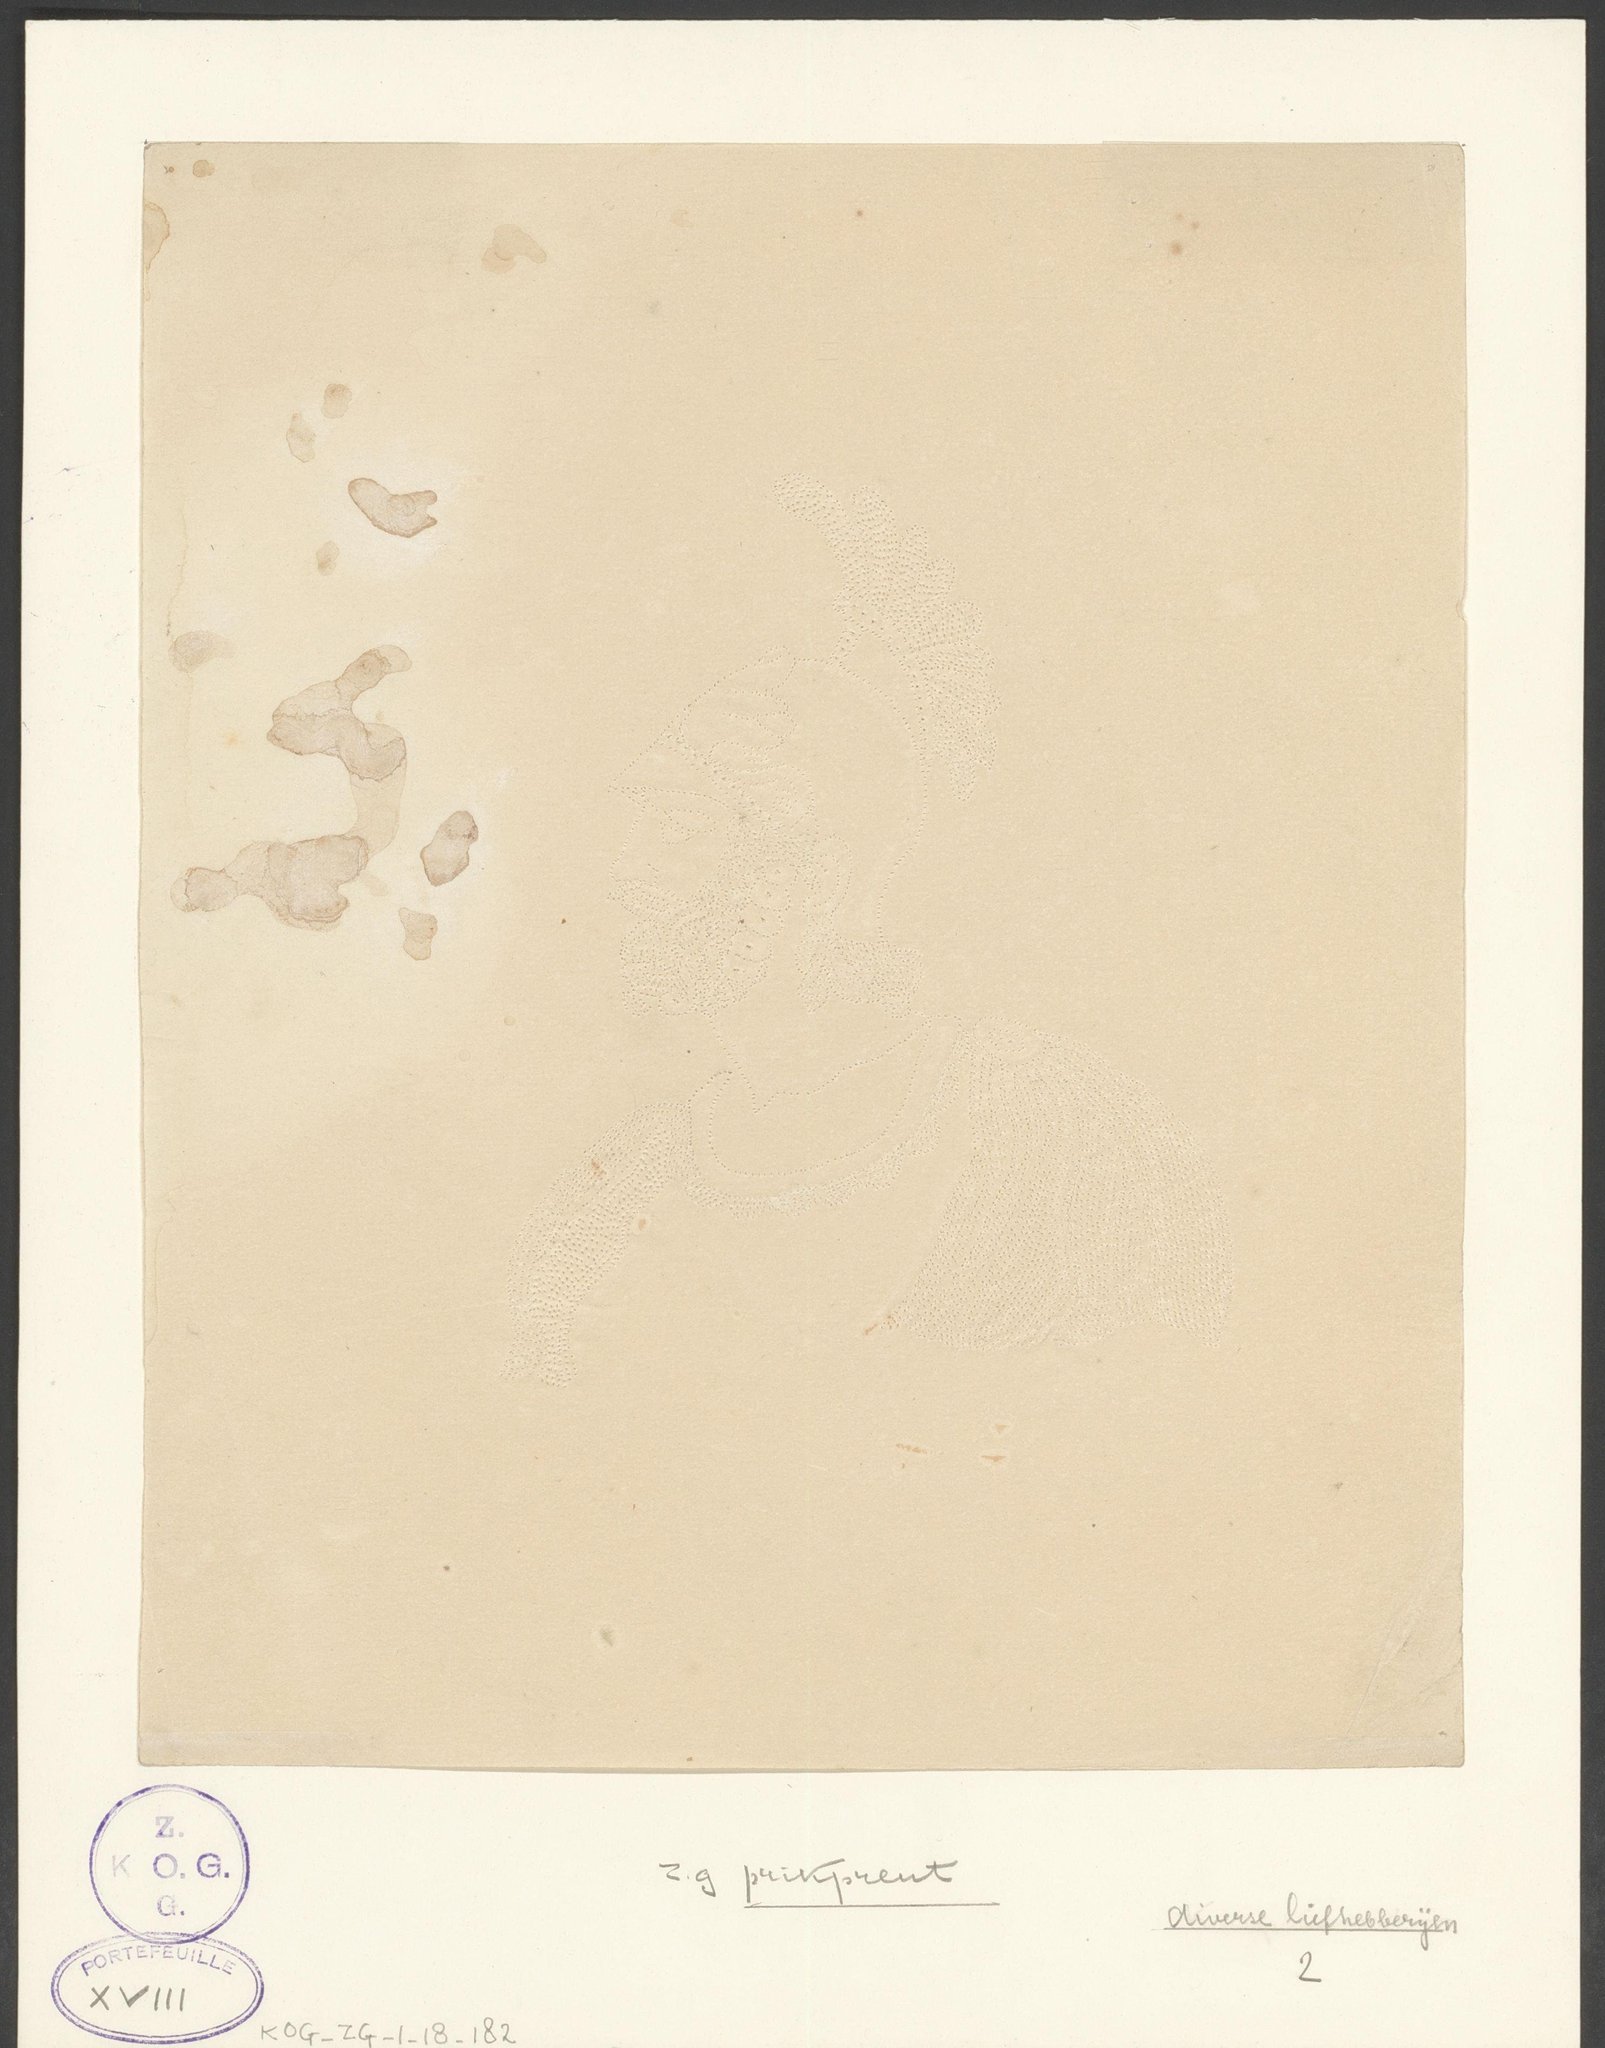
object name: drawing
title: Mars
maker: Anonymous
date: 1800-1899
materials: paper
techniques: pricking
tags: helmet, (story of) mars (ares)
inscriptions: stamp, collector's mark: Lugt 1641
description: Mars met helm en profil. Onderwerpsrubrieken binnen de Atlas Zeden en Gewoonten: Schoone kunsten, Diverse liefhebberijen (o.a. prikprenten).